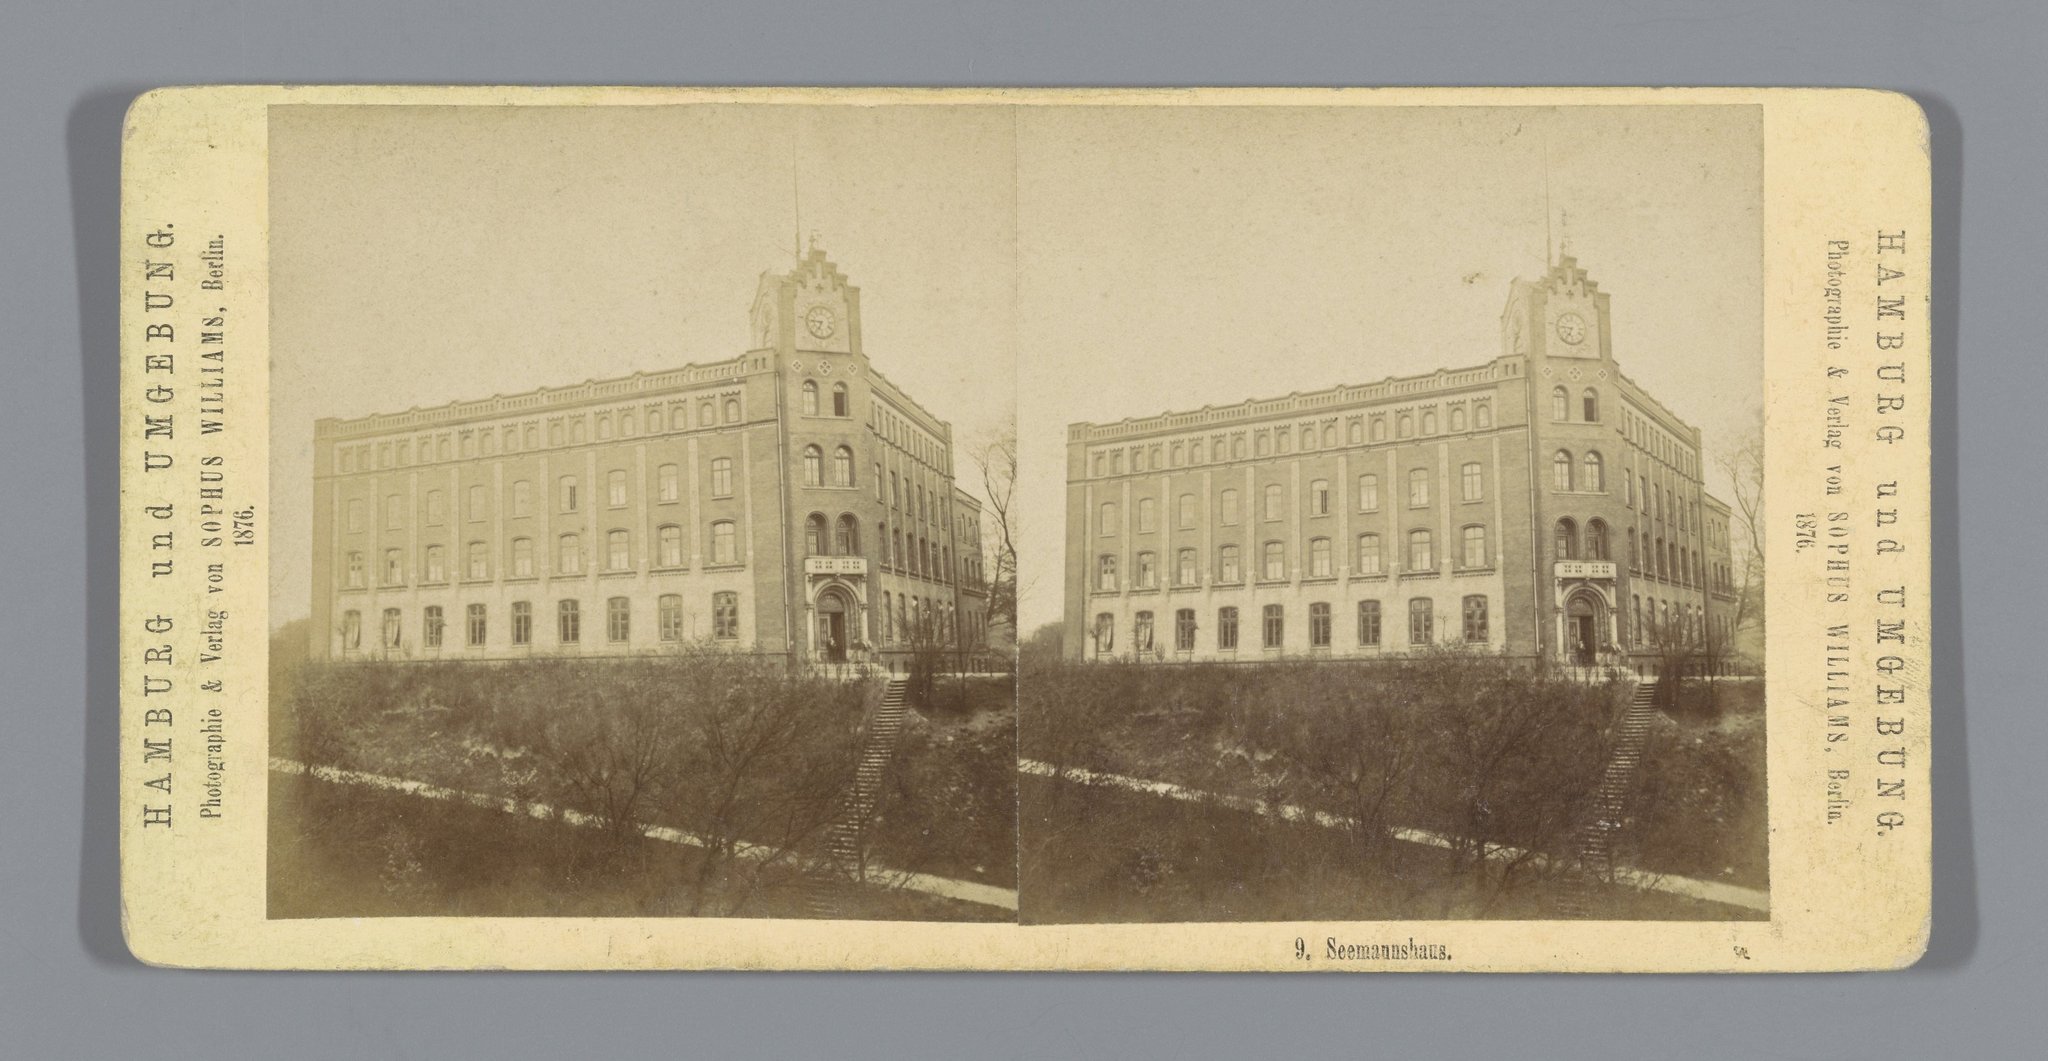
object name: stereograph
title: Exterieur van het Seemannshaus te Hamburg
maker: sophus williams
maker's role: publisher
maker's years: 1835-1900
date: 1876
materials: cardboard, photographic support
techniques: albumen print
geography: hamburg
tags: seemannshaus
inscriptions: number: ‘9.’